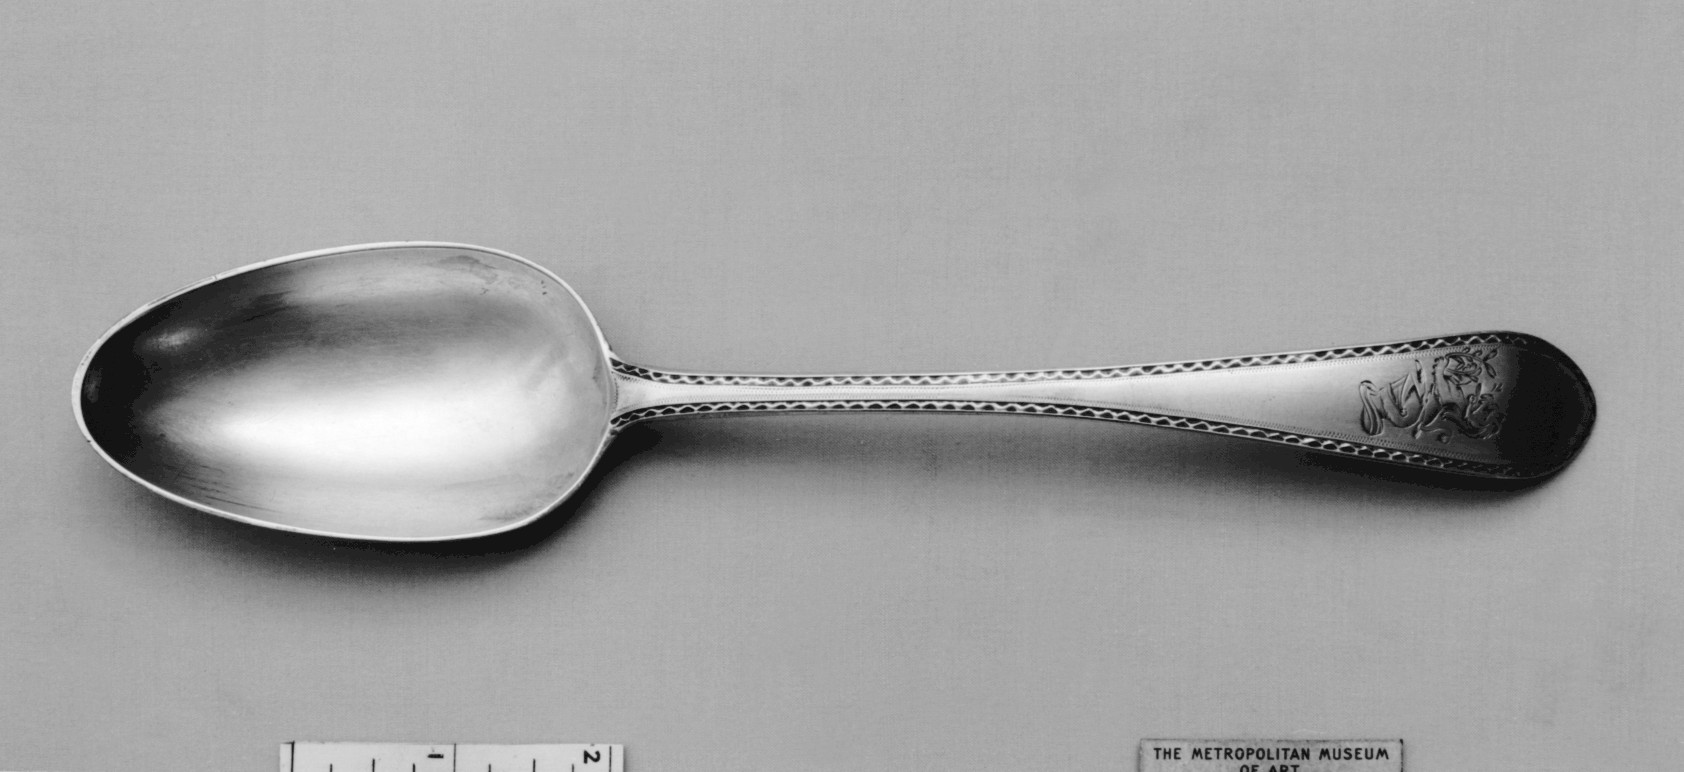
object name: tablespoon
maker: john pittar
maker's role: maker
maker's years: 1778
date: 1780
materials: silver